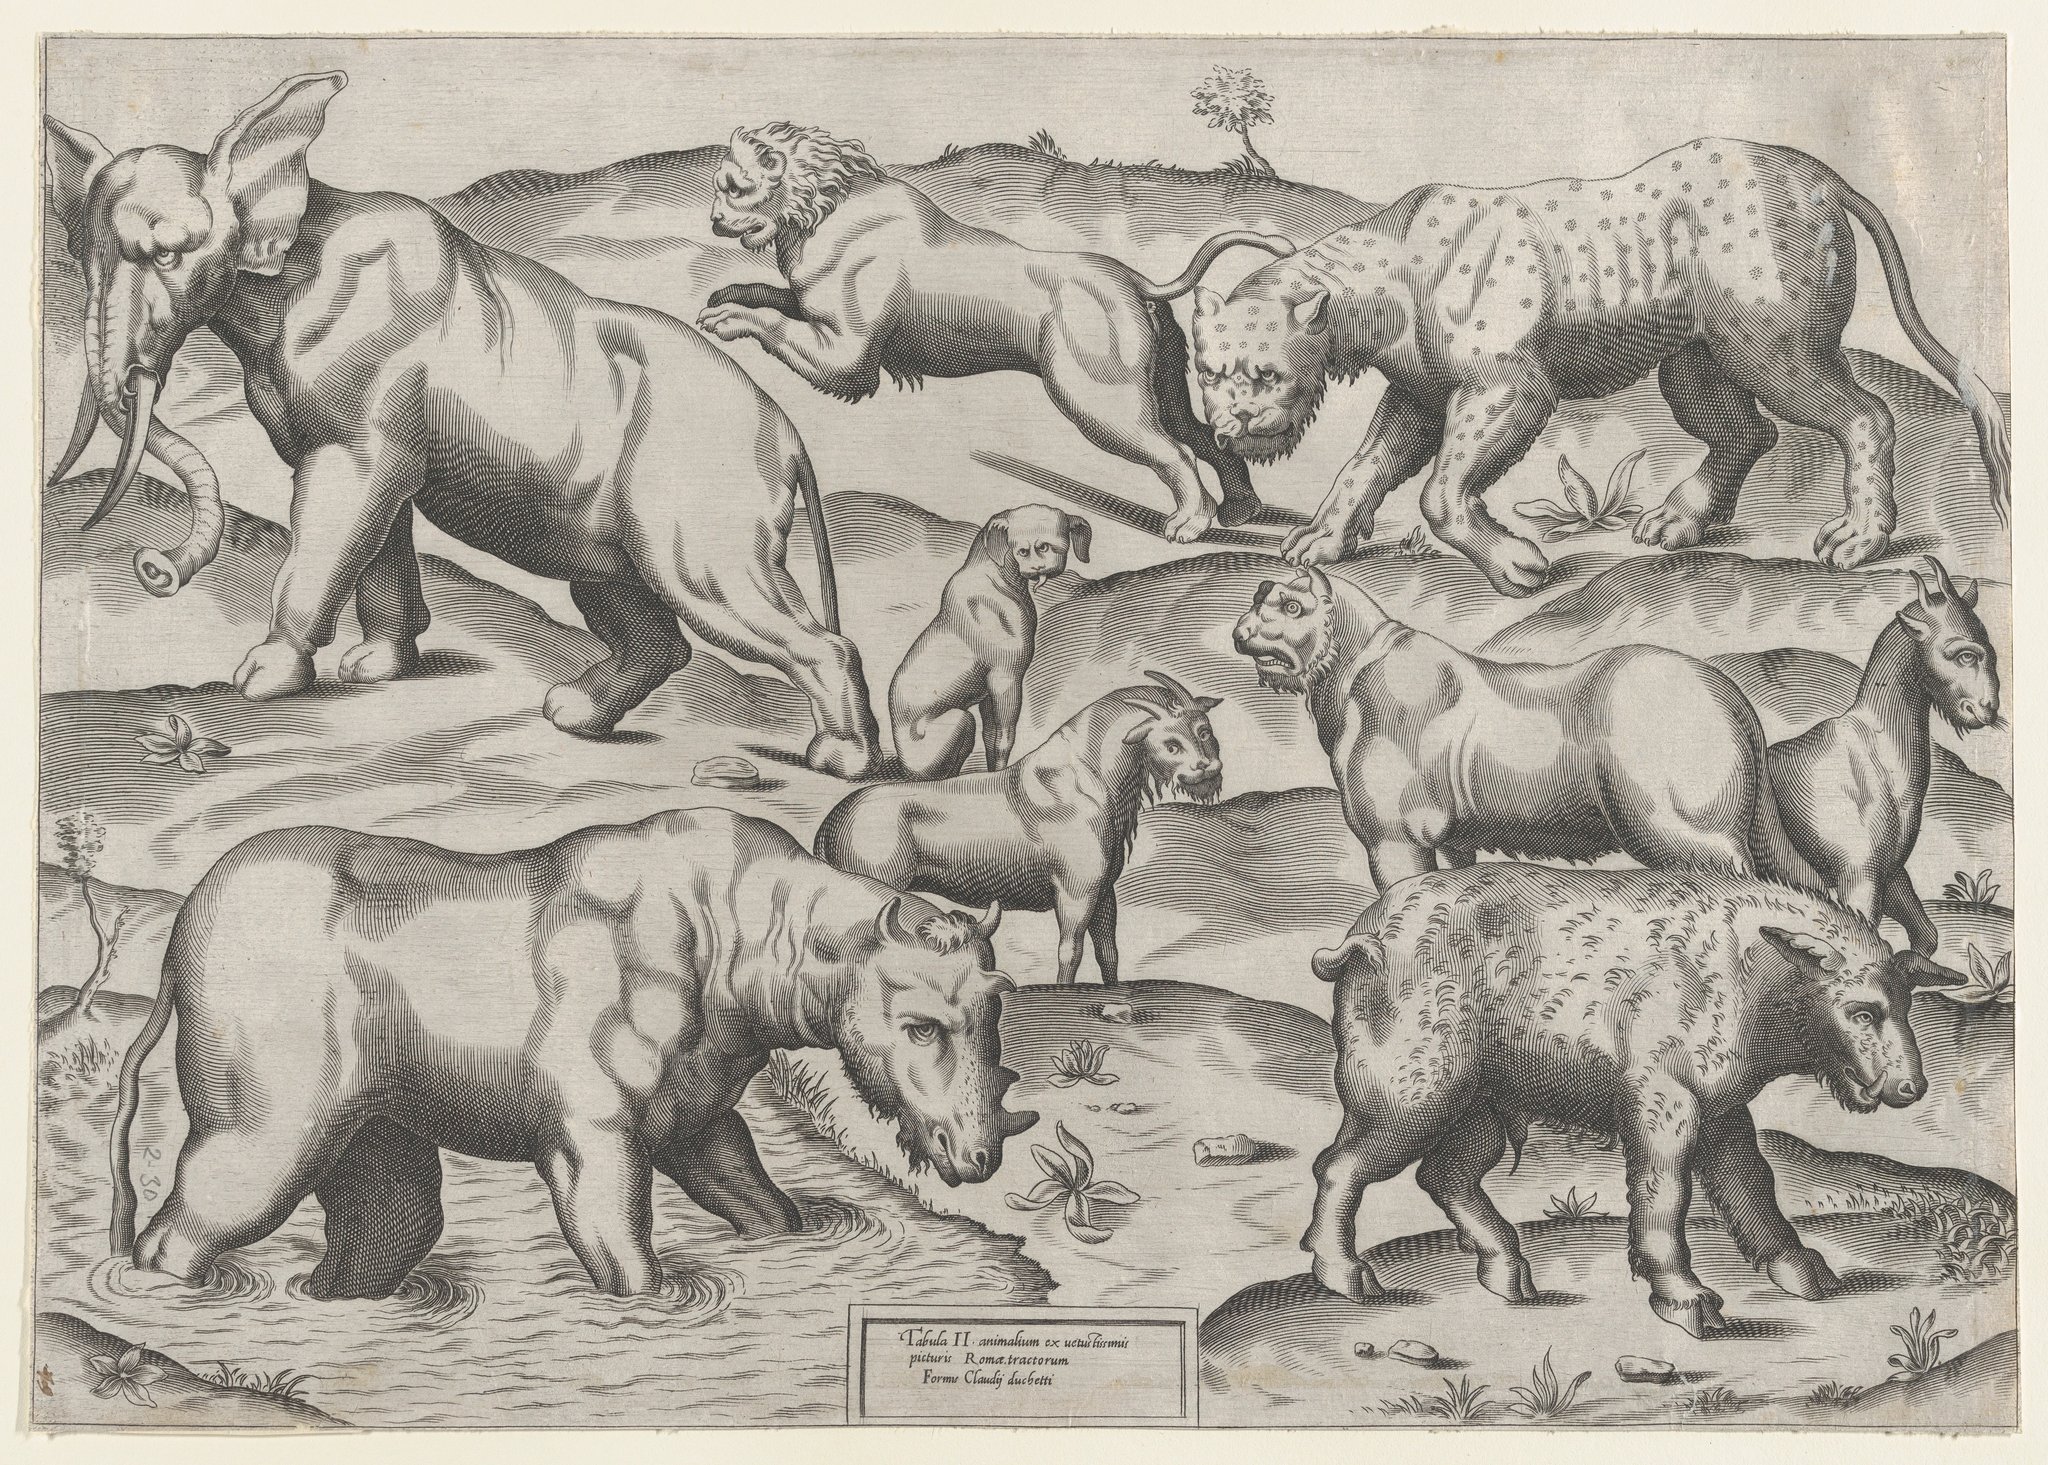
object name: print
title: Wild Animals, from antique wall paintings, plate 2, from "Speculum Romanae Magnificentiae"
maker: Anonymous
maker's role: artist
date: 1567-1600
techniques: engraving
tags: boars,elephants,lions